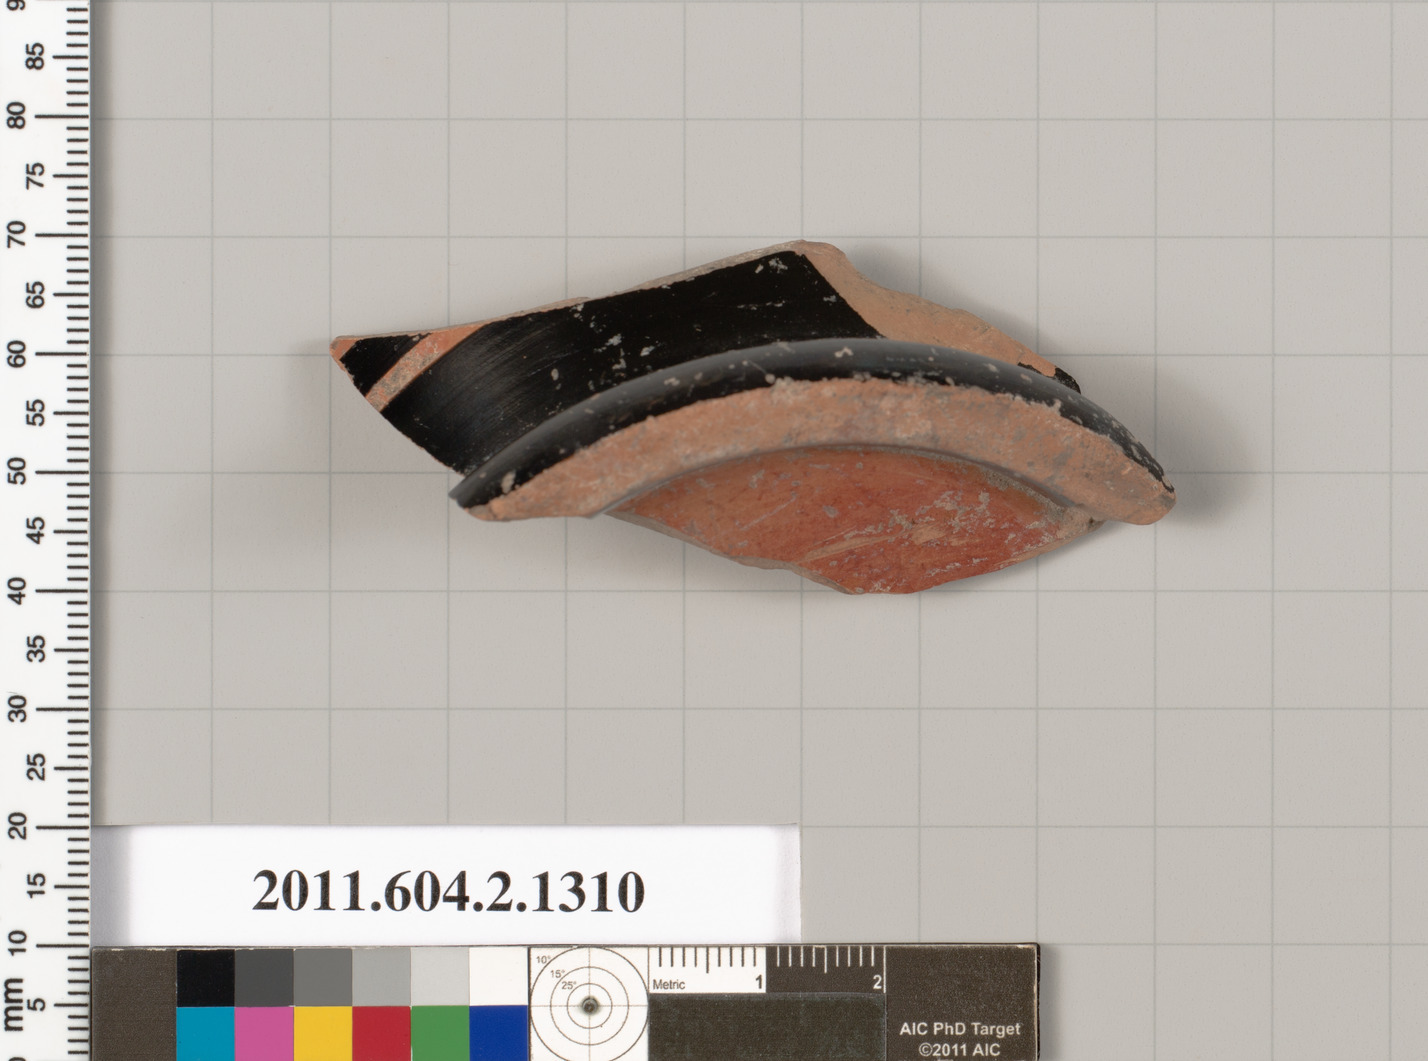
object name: skyphos fragment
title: Terracotta fragment of a skyphos (deep drinking cup)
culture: greek, attic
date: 500-451 BCE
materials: terracotta